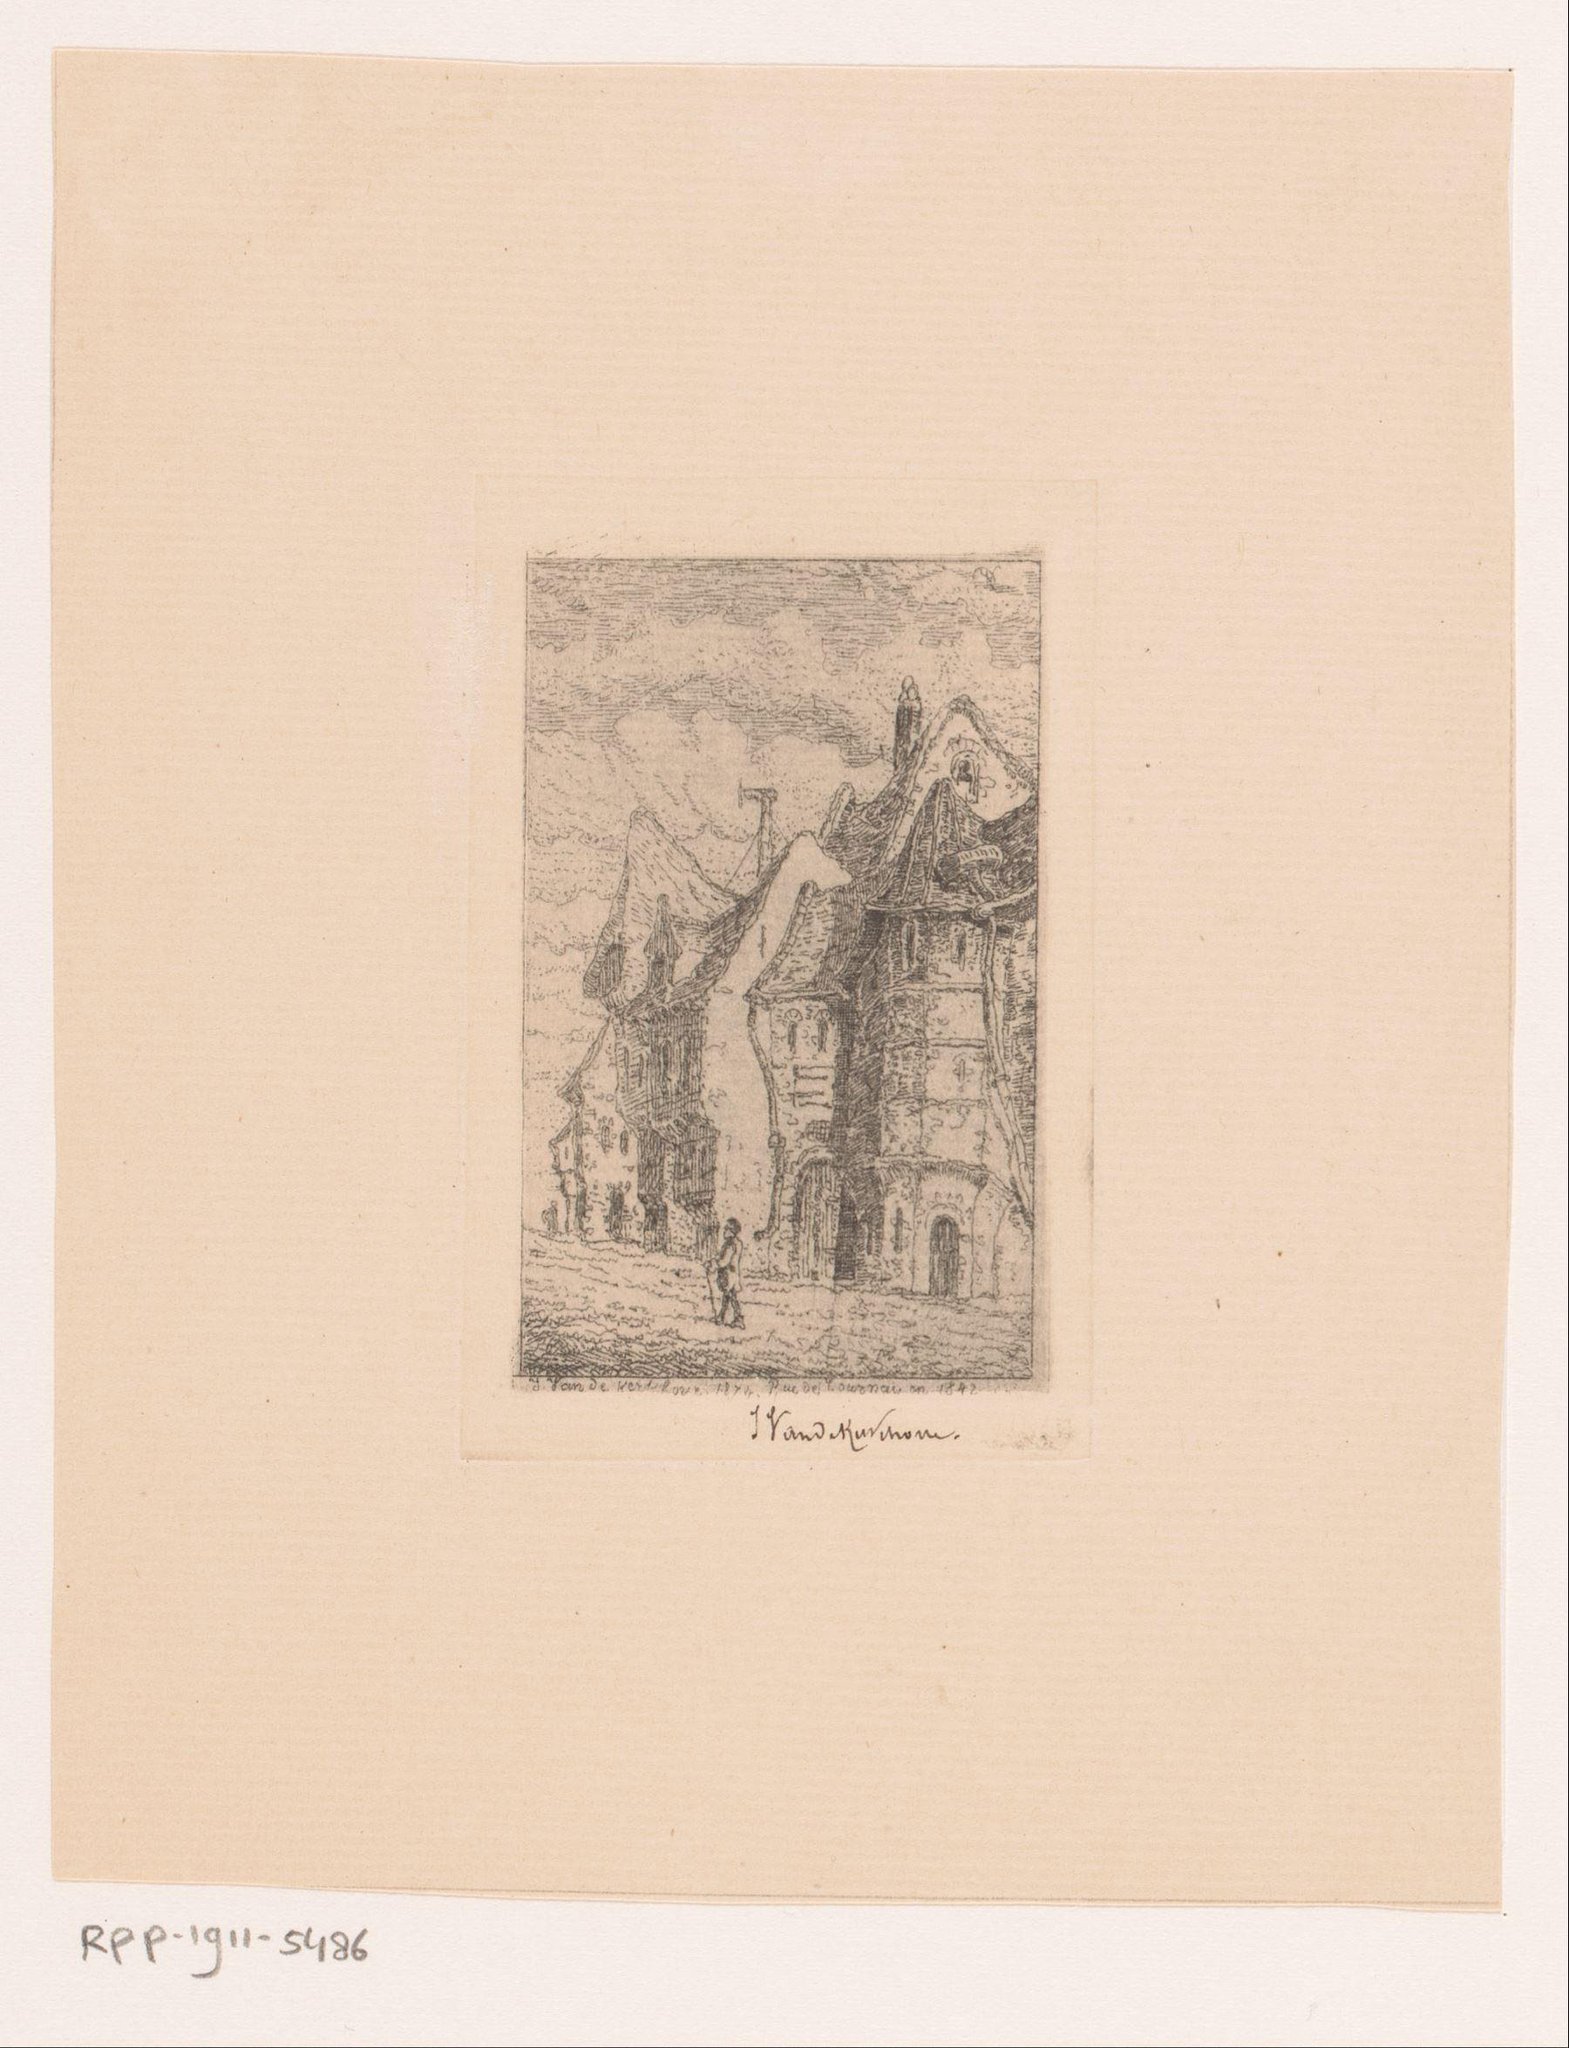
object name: print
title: Gezicht op Rue de Tournai, 1842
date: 1874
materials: paper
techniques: etching, intaglio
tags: street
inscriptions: collector's mark: Lugt 2228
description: De etsen naar de schilderijen van Frédéric Van de Kerkhove werden na zijn dood door zijn vader en zuster gemaakt en uitgegeven in twee reeksen. De eerste werd in 1877 uitgegeven door het Journal des Beaux-Arts et de la Littérature: Cahier de 25 Eaux-fortes d'après Frédéric van de Kerkhove, gravées par son père et sa sœur. De tweede reeks van 126 etsen, ook in 1877, werd in Parijs uitgegeven bij A. Lévy onder de titel Cent eaux-fortes gravées par J. Van de Kerkhove d'après les tableaux de Frédéric Van de Kerkhove, mort en 1873 à l'âge de 10 ans et 11 mois.